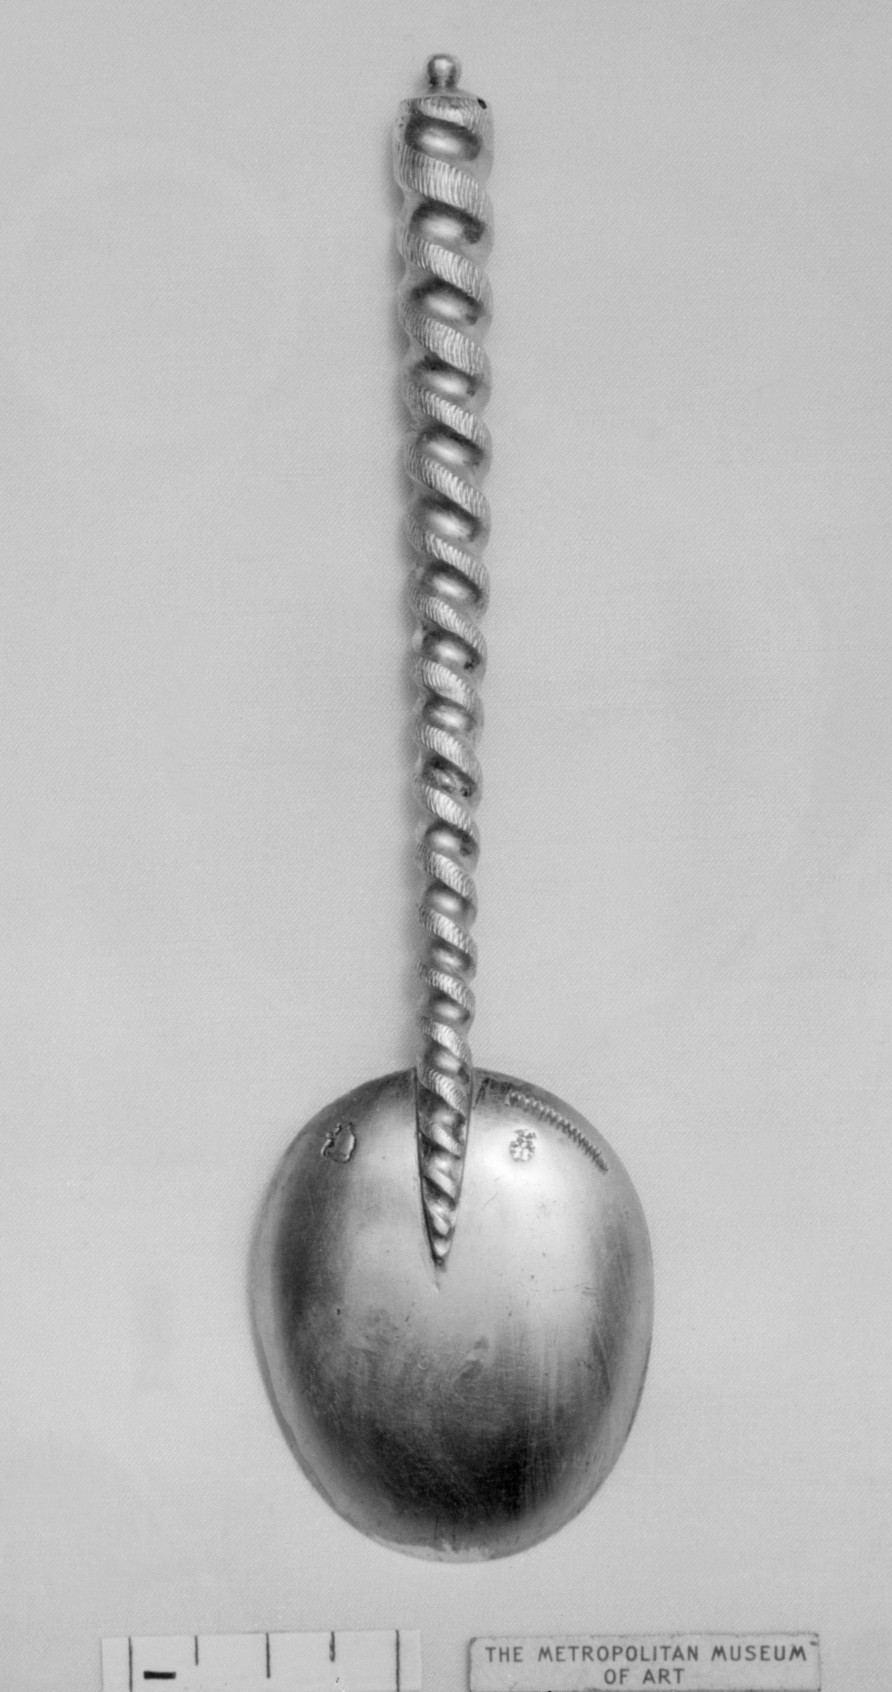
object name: spoon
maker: michael hafner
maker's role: maker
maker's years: 1665-1700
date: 1674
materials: silver gilt